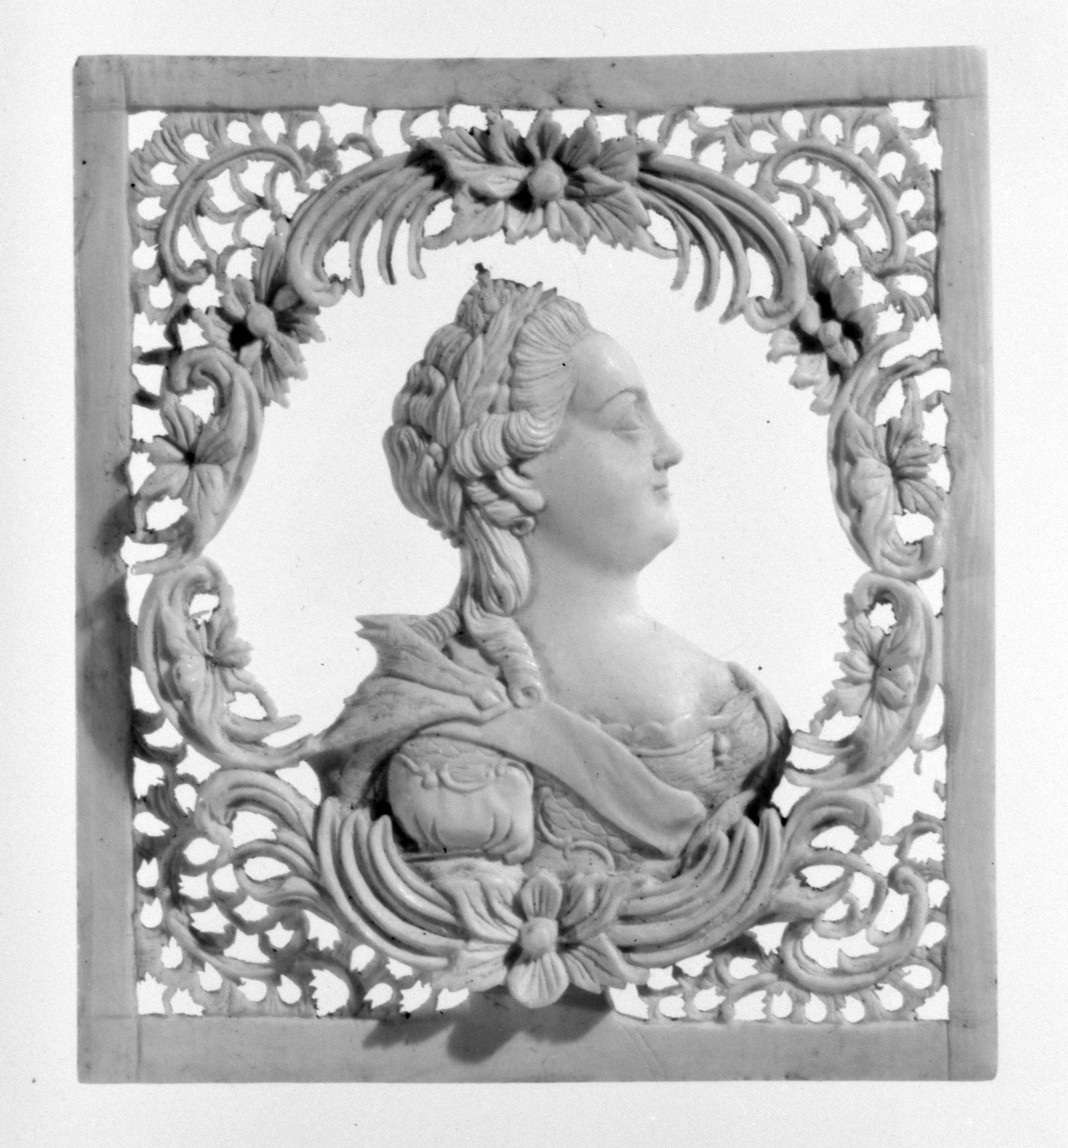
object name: plaque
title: Catherine II (Catherine the Great)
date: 1767-1833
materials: ivory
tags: profiles,women